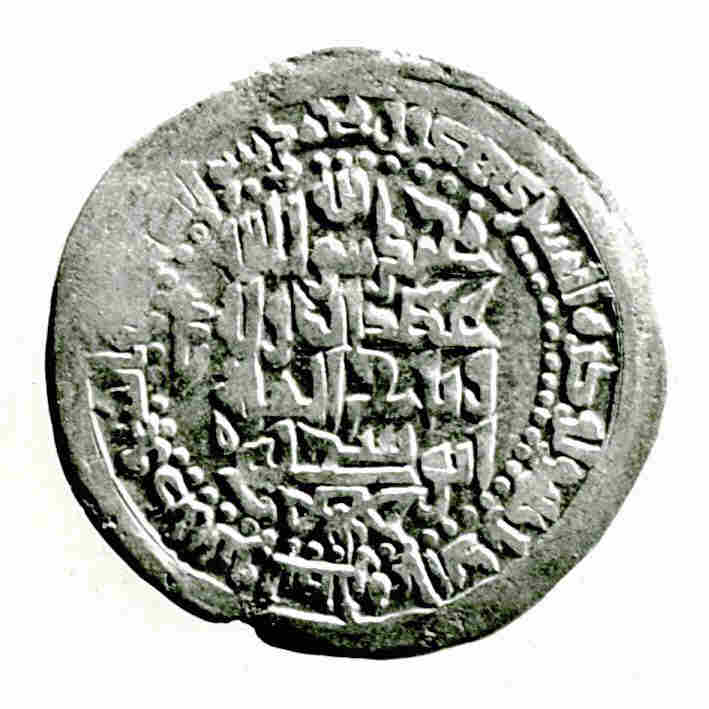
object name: coin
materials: silver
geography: astar-abad